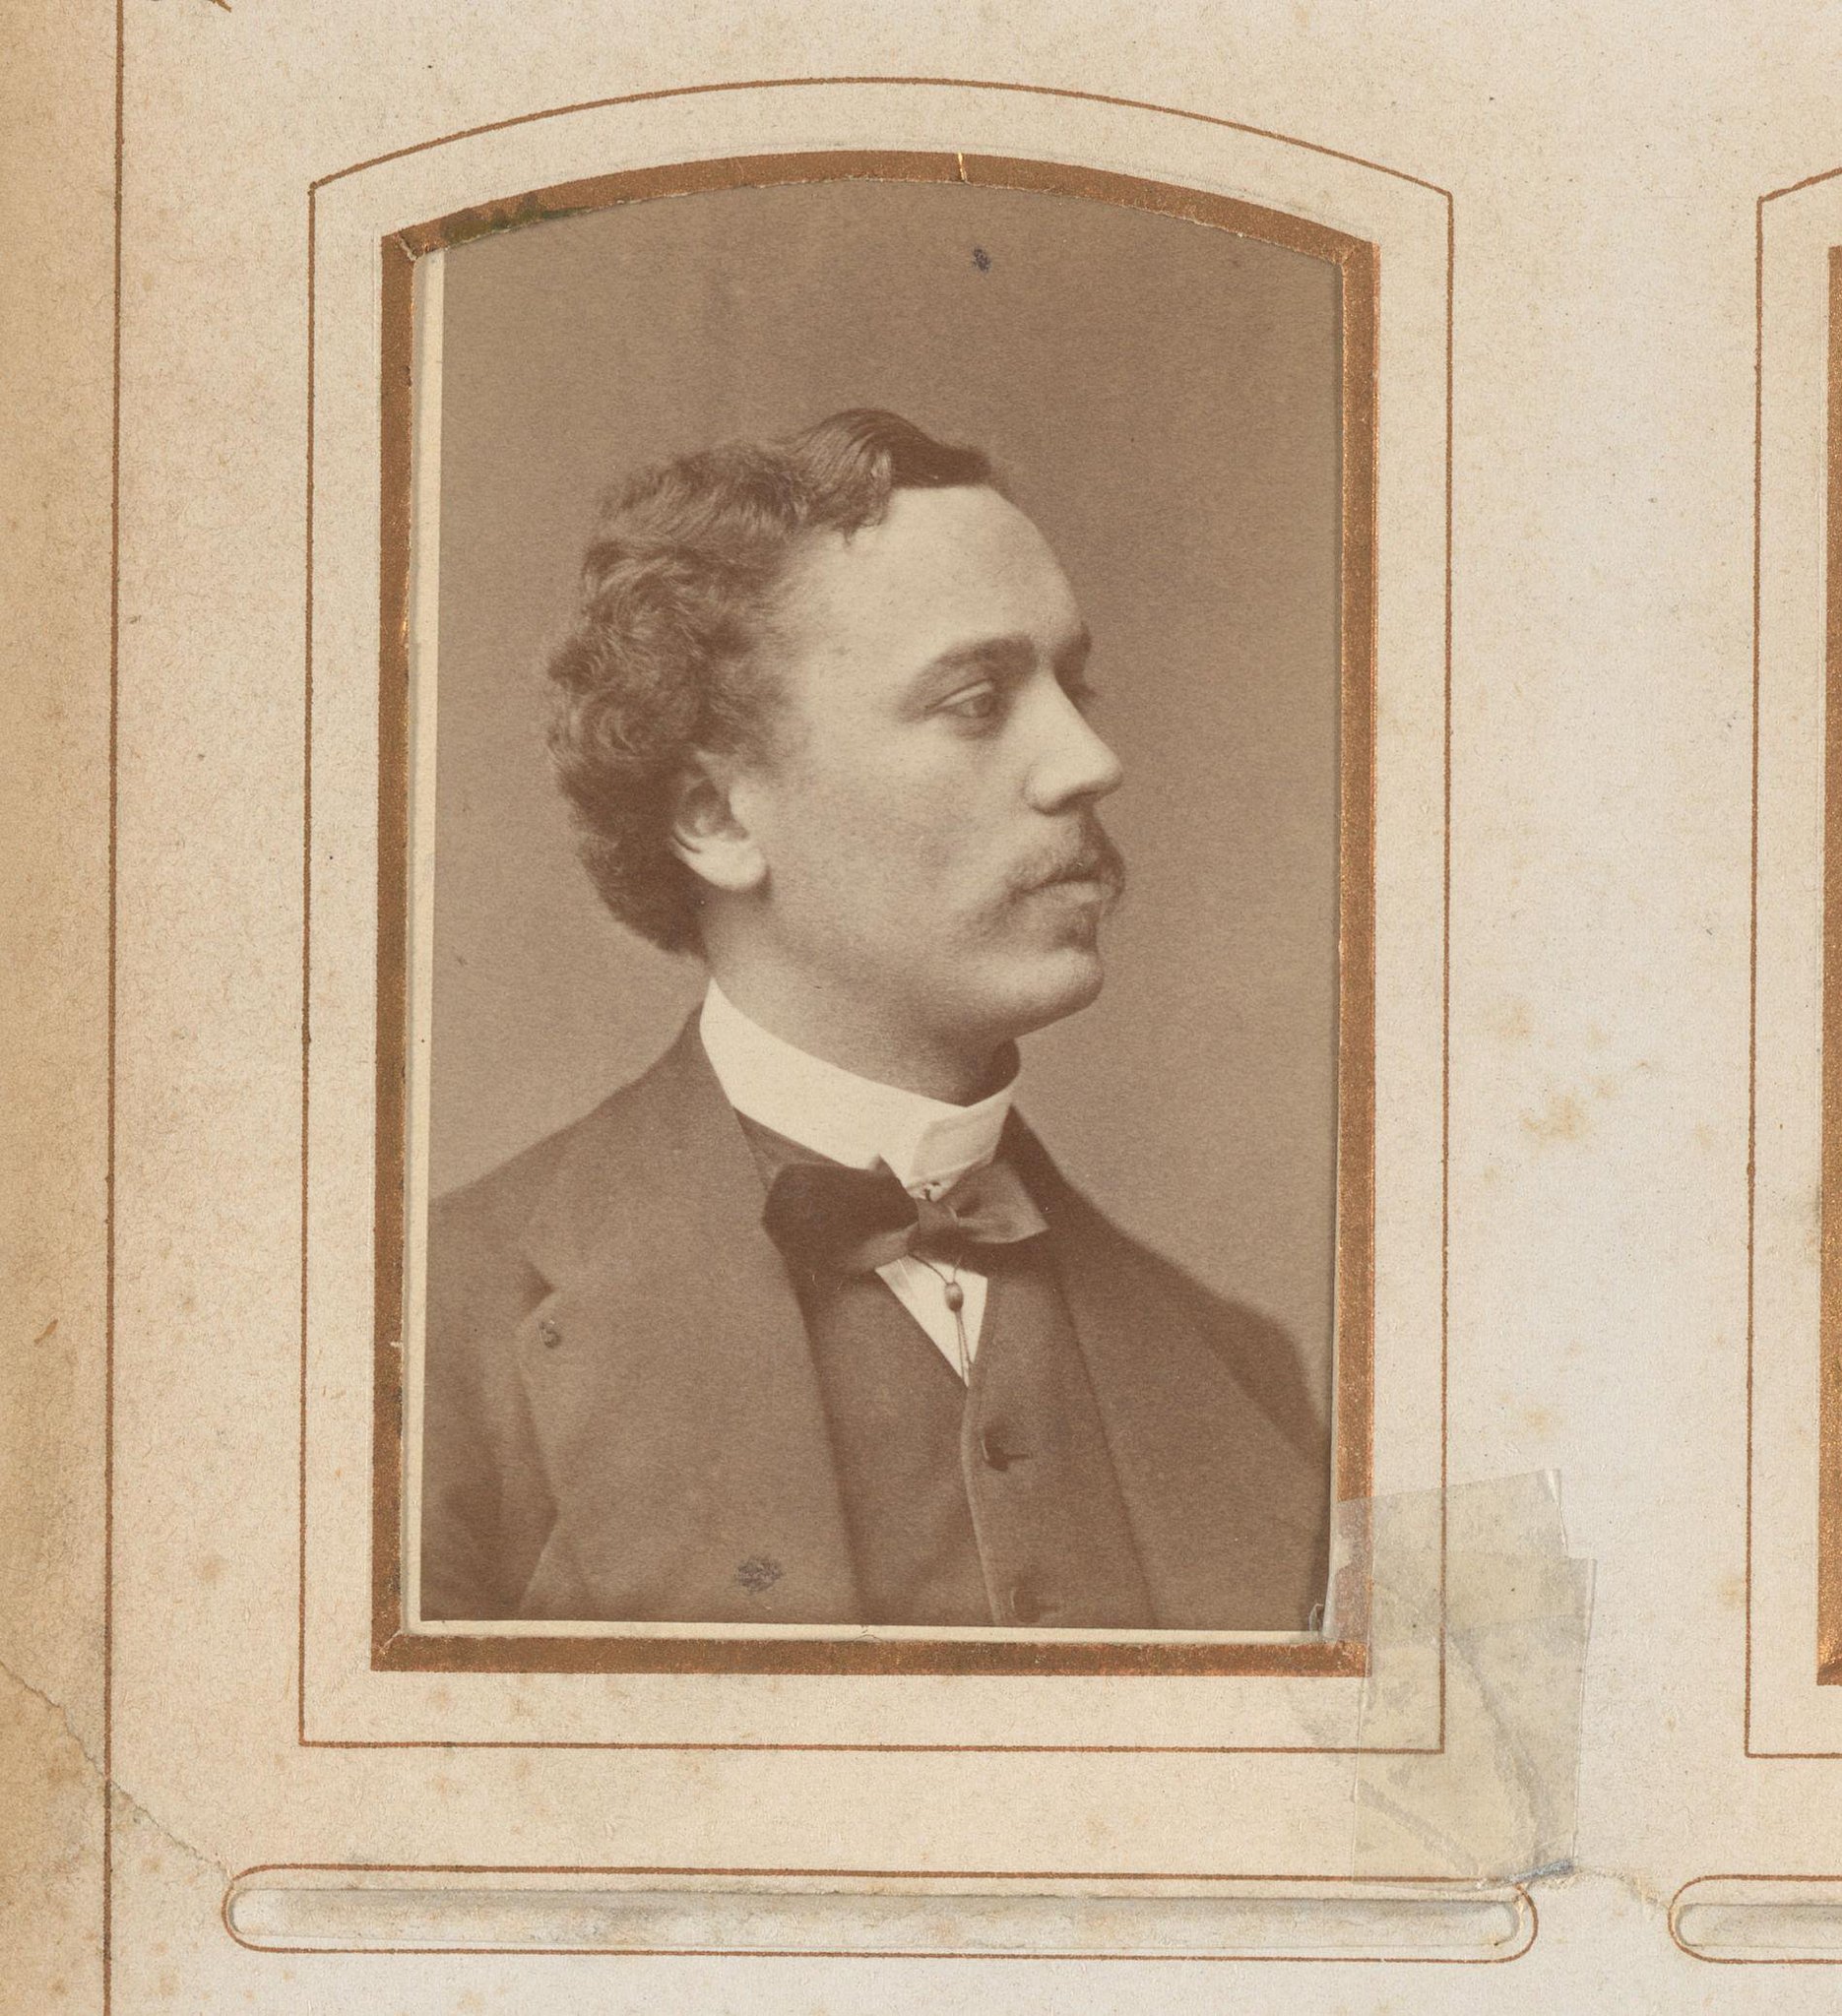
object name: carte de visite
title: Portret van een man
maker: gösta florman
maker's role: fotograaf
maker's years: 1831-1900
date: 1860-1900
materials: cardboard, photographic support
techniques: albumen print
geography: stockholm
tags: historical persons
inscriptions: inscription: ‘Gösta Florman./ STOCKHOLM/ 28A Regeringsgatan 28 A./ Odeon.’